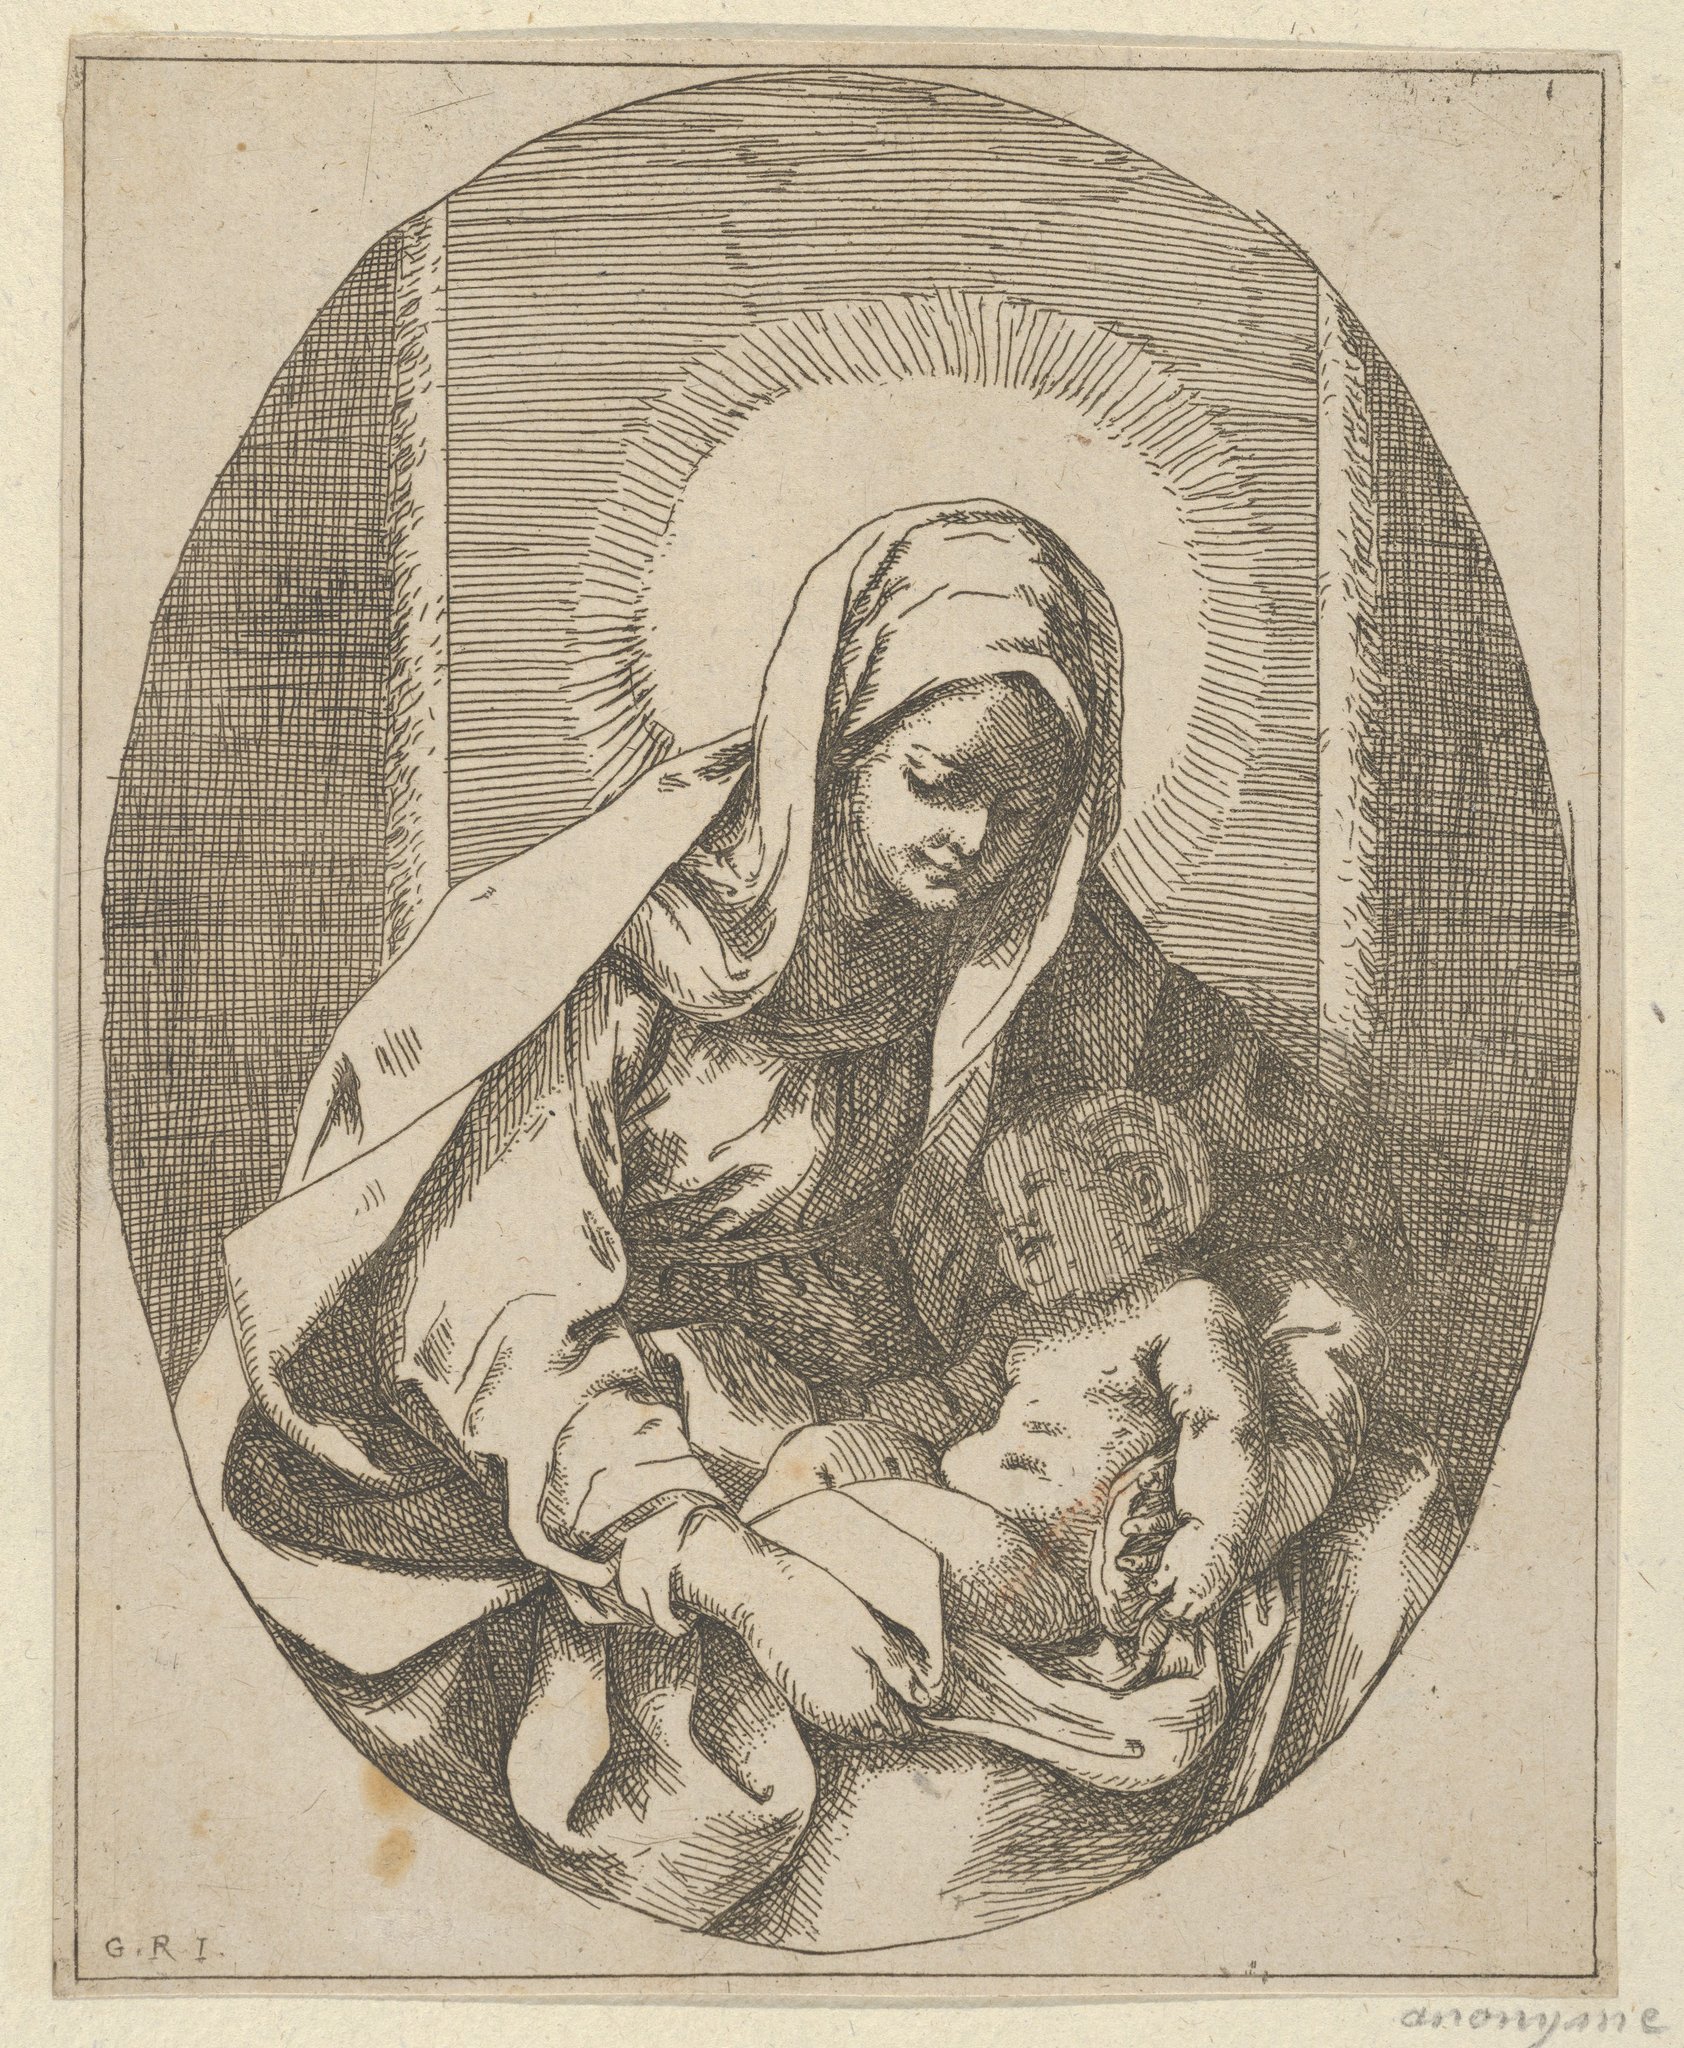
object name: print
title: The Virgin holding the infant Christ on her lap, an oval composition, after Reni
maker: guido reni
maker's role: artist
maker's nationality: italian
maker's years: 1575-1642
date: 1620-1650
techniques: etching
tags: madonna and child